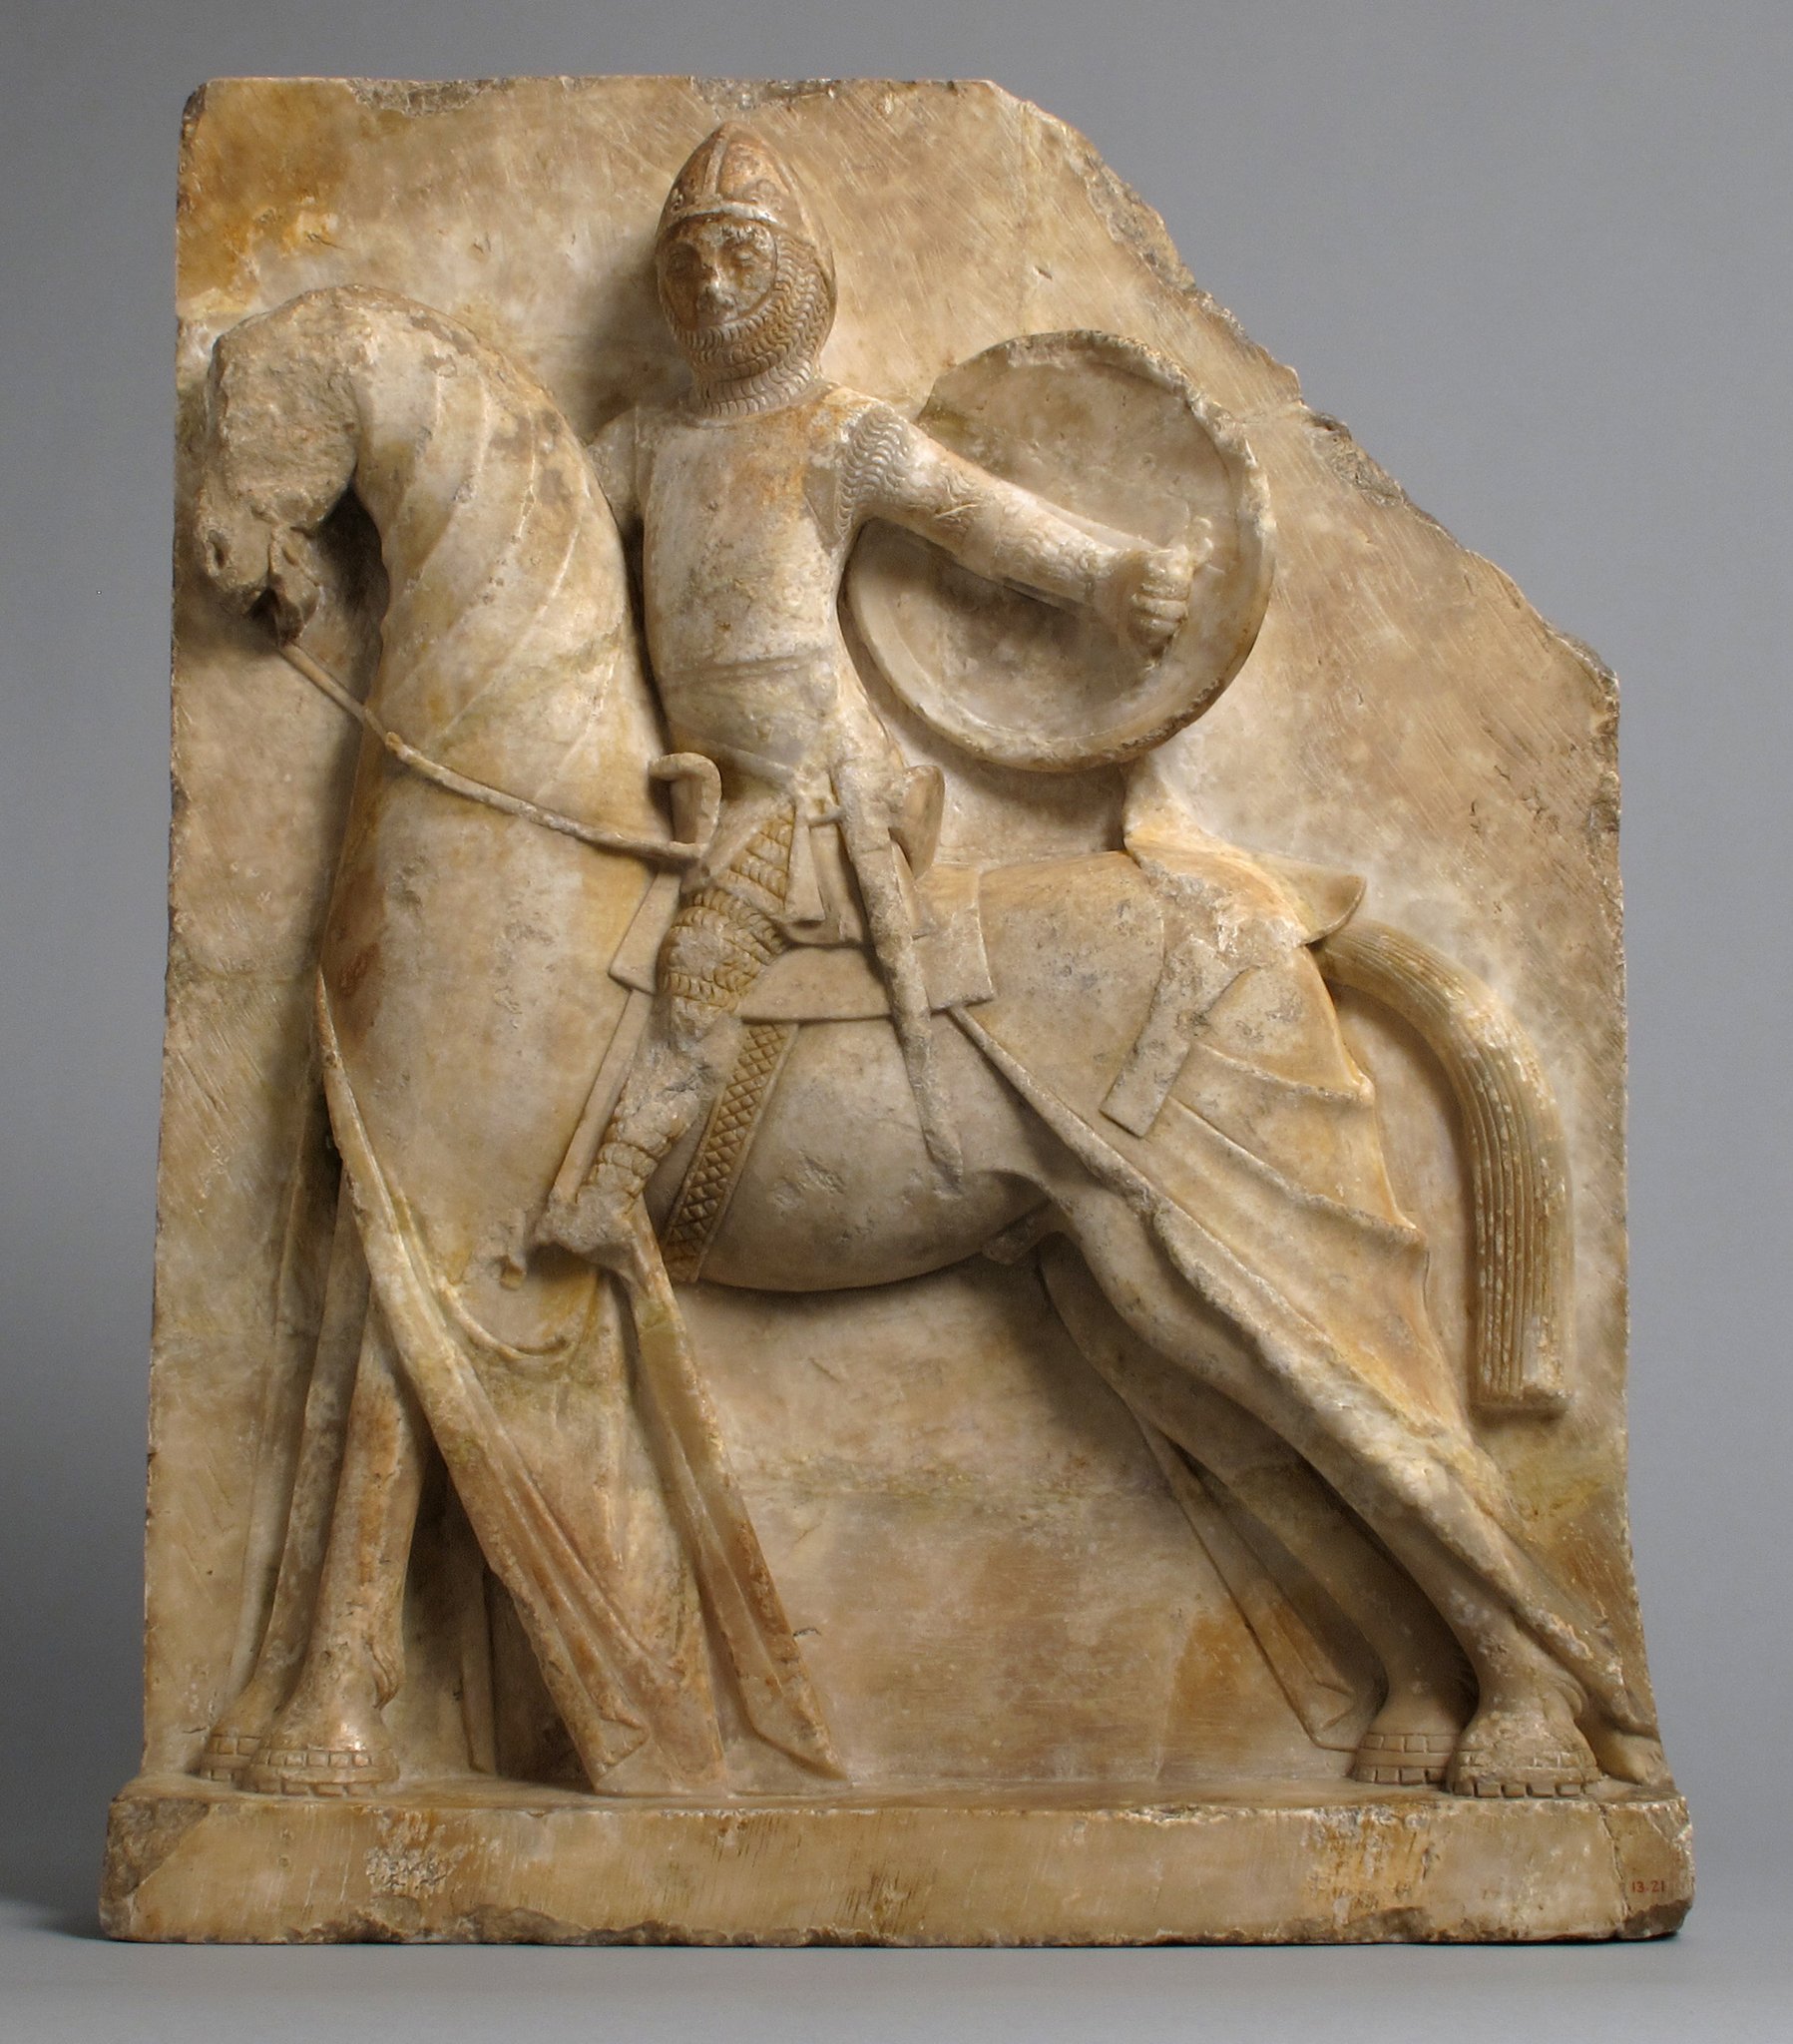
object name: relief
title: Relief Panel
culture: spanish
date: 1201-1300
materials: alabaster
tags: horses